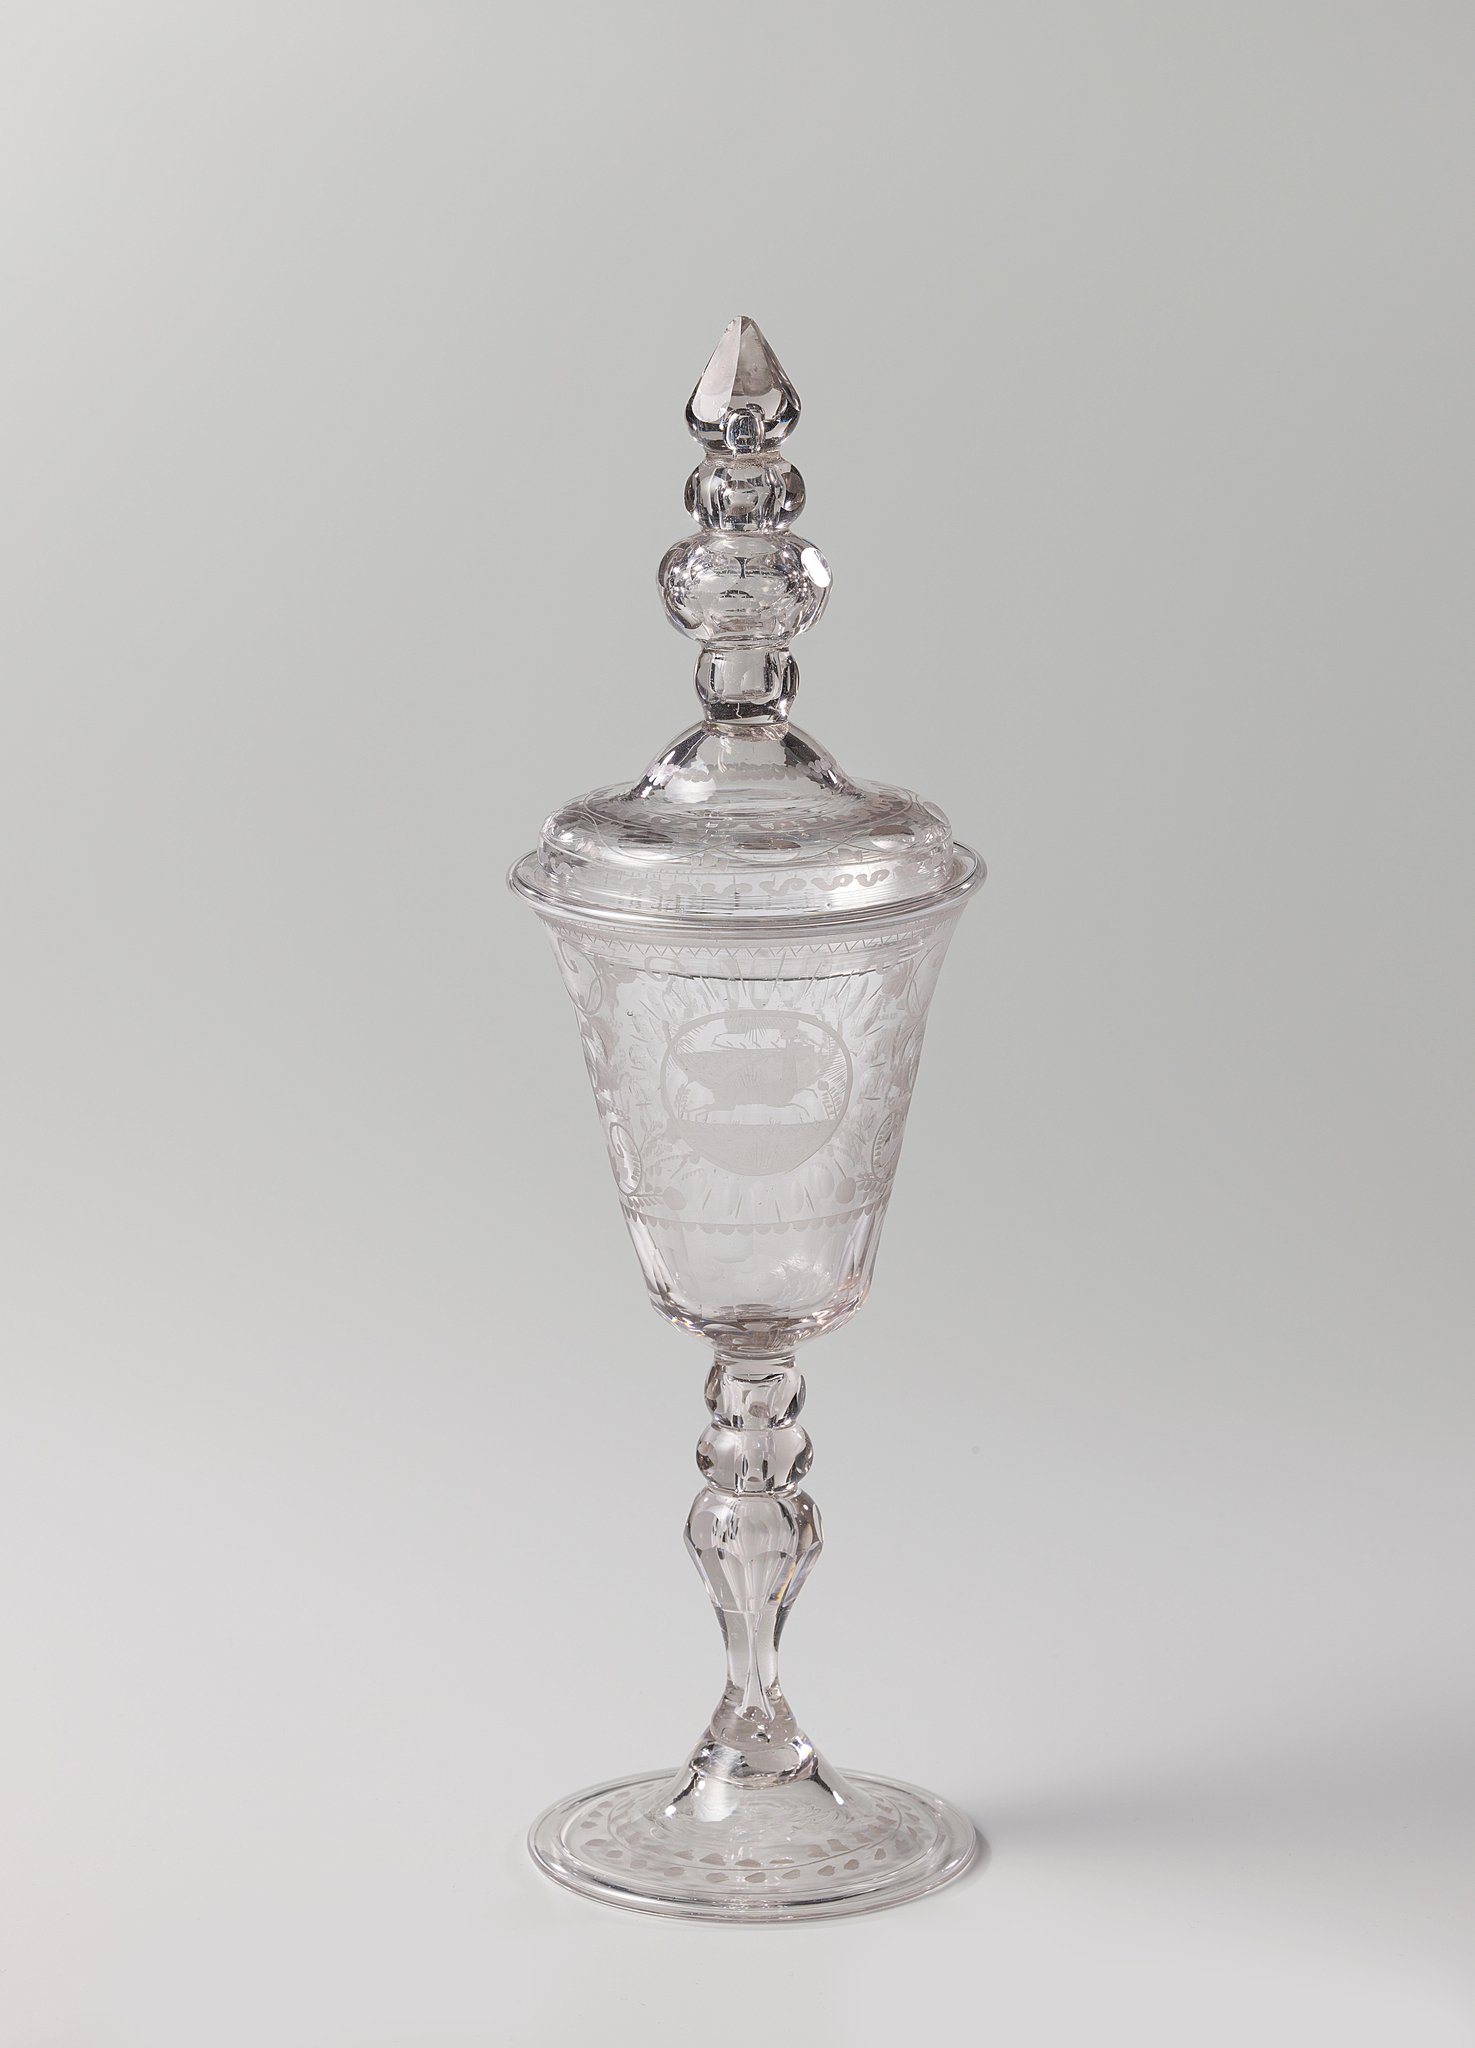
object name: lid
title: Deksel van een bokaal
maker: Anonymous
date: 1725-1750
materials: glass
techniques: glassblowing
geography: bohemia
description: Gewelfde deksel, bekroond met gelede dekselknop, bestaande uit drie gefaceteerde knopen en een gefacetteerde, peervormige uiteinde. Op de deksel lijnornamenten.